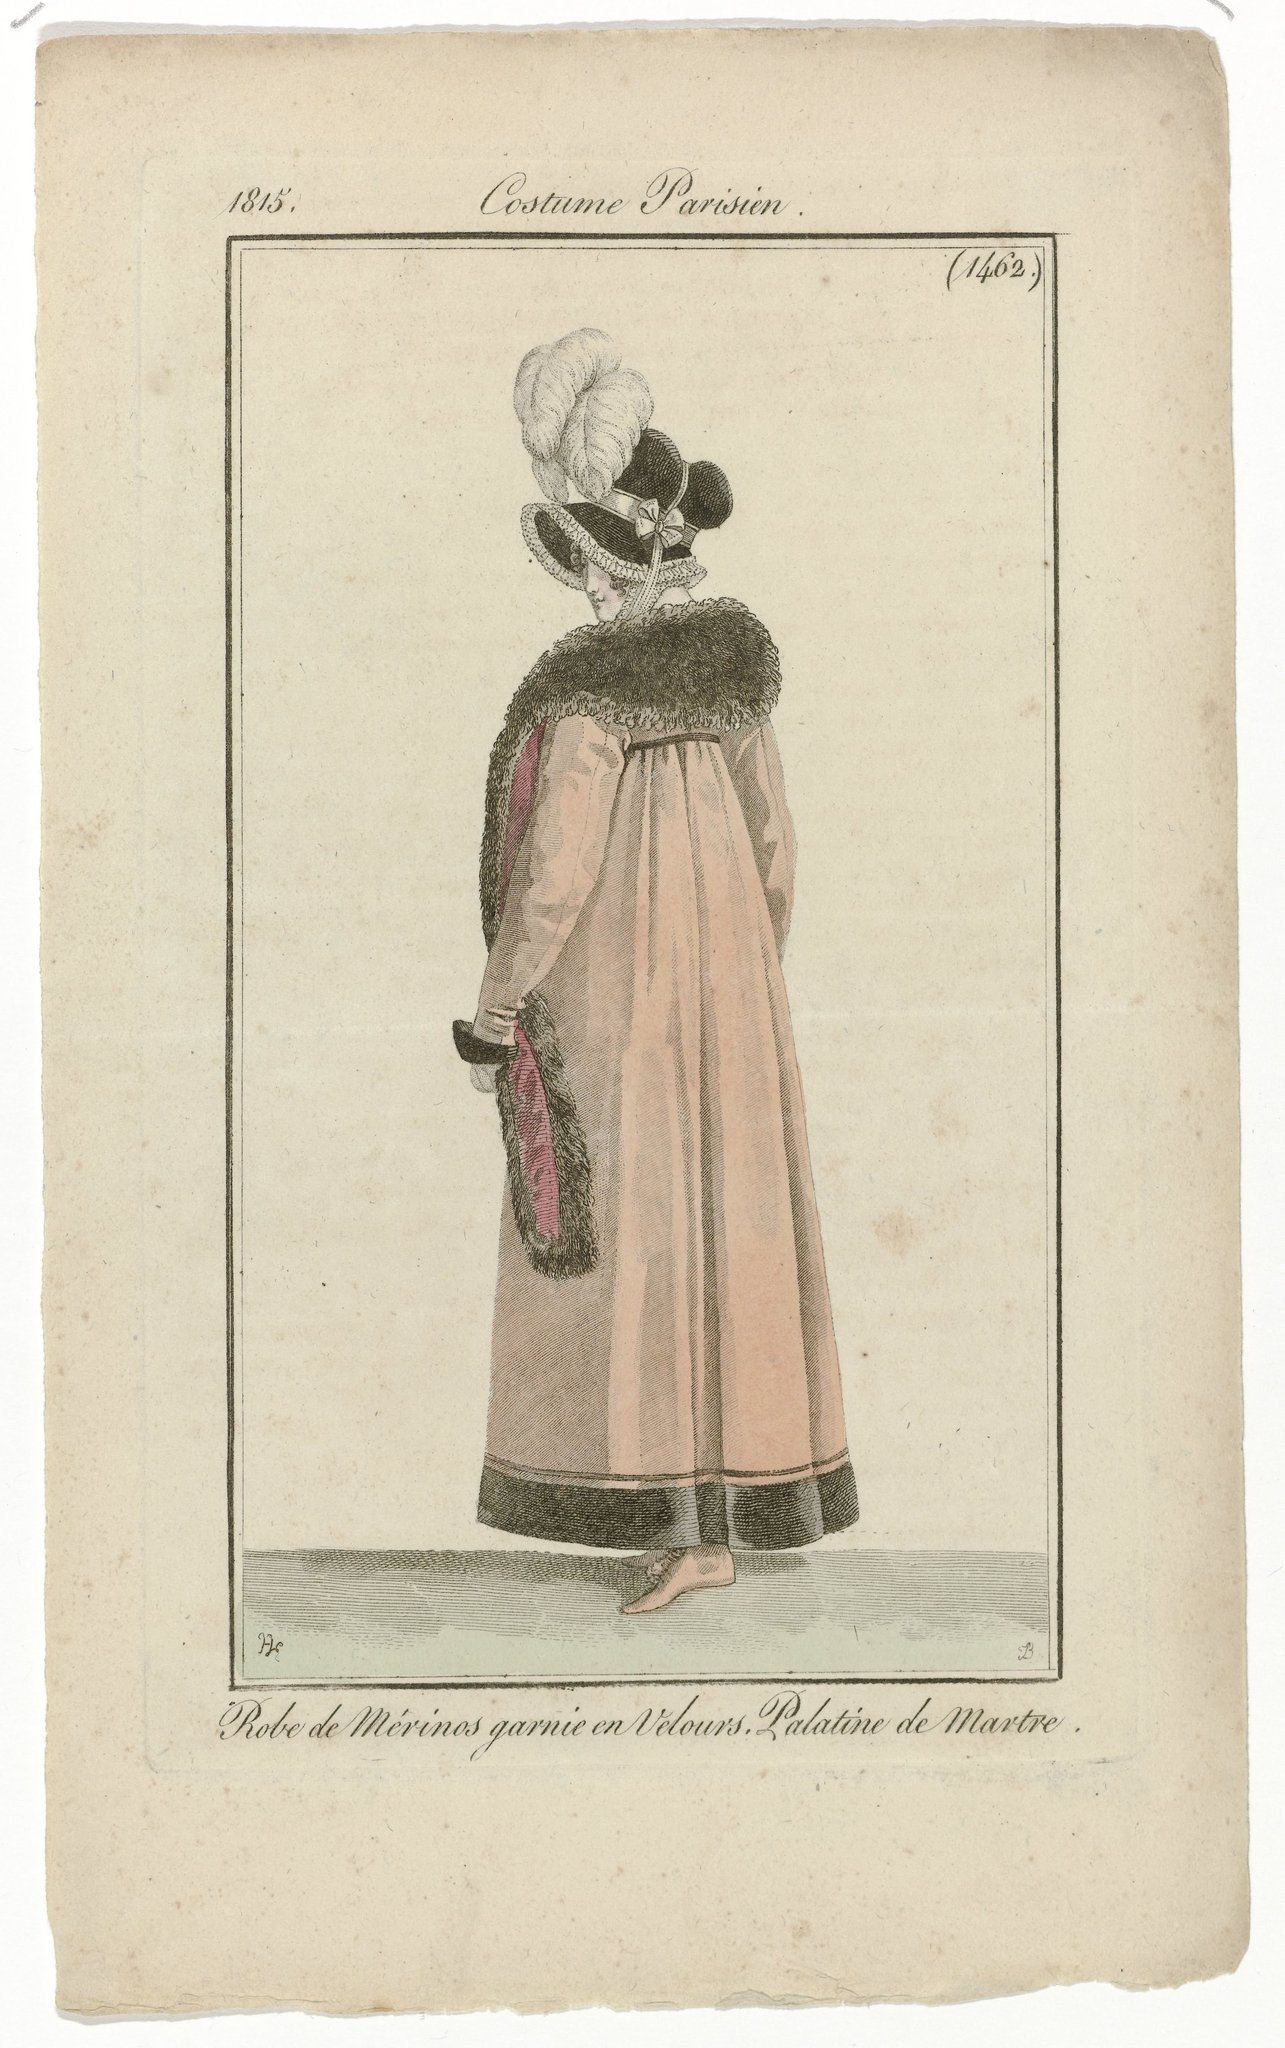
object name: fashion print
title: Journal des Dames et des Modes: Ladies’ Fashion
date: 1815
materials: paper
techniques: engraving, hand coloring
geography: paris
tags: clothing for the upper part of the body (shawl) (+ women's clothes), neck-gear ~ clothing (palatine) (+ women's clothes), fashion plates, head-gear: hat (+ women's clothes), shoes, sandals (+ women's clothes), dress, gown (+ women's clothes)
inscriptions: caption: ‘Robe de Mérinos garnie en velours. Palatine de Martre.’, title: ‘Costume Parisien.’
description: After the turbulent years of the French Revolution, in 1797 a fashion magazine was finally published again: the Journal des Dames et des Modes. Under the direction of Pierre de La Mésangère, it developed a cosmopolitan flair. The very best draughtsmen were recruited to produce the fashion illustrations, called Costumes Parisiens. They visited spots all over Paris to ensure they saw the latest styles. These included high-waisted gowns with low necklines, ‘Greek’ slippers with cross-laces 1, genuine Kashmiri shawls 2, reticules 3 (small stylish handbags), poke bonnets 4 and full-length English coats knowns as redingotes 5.